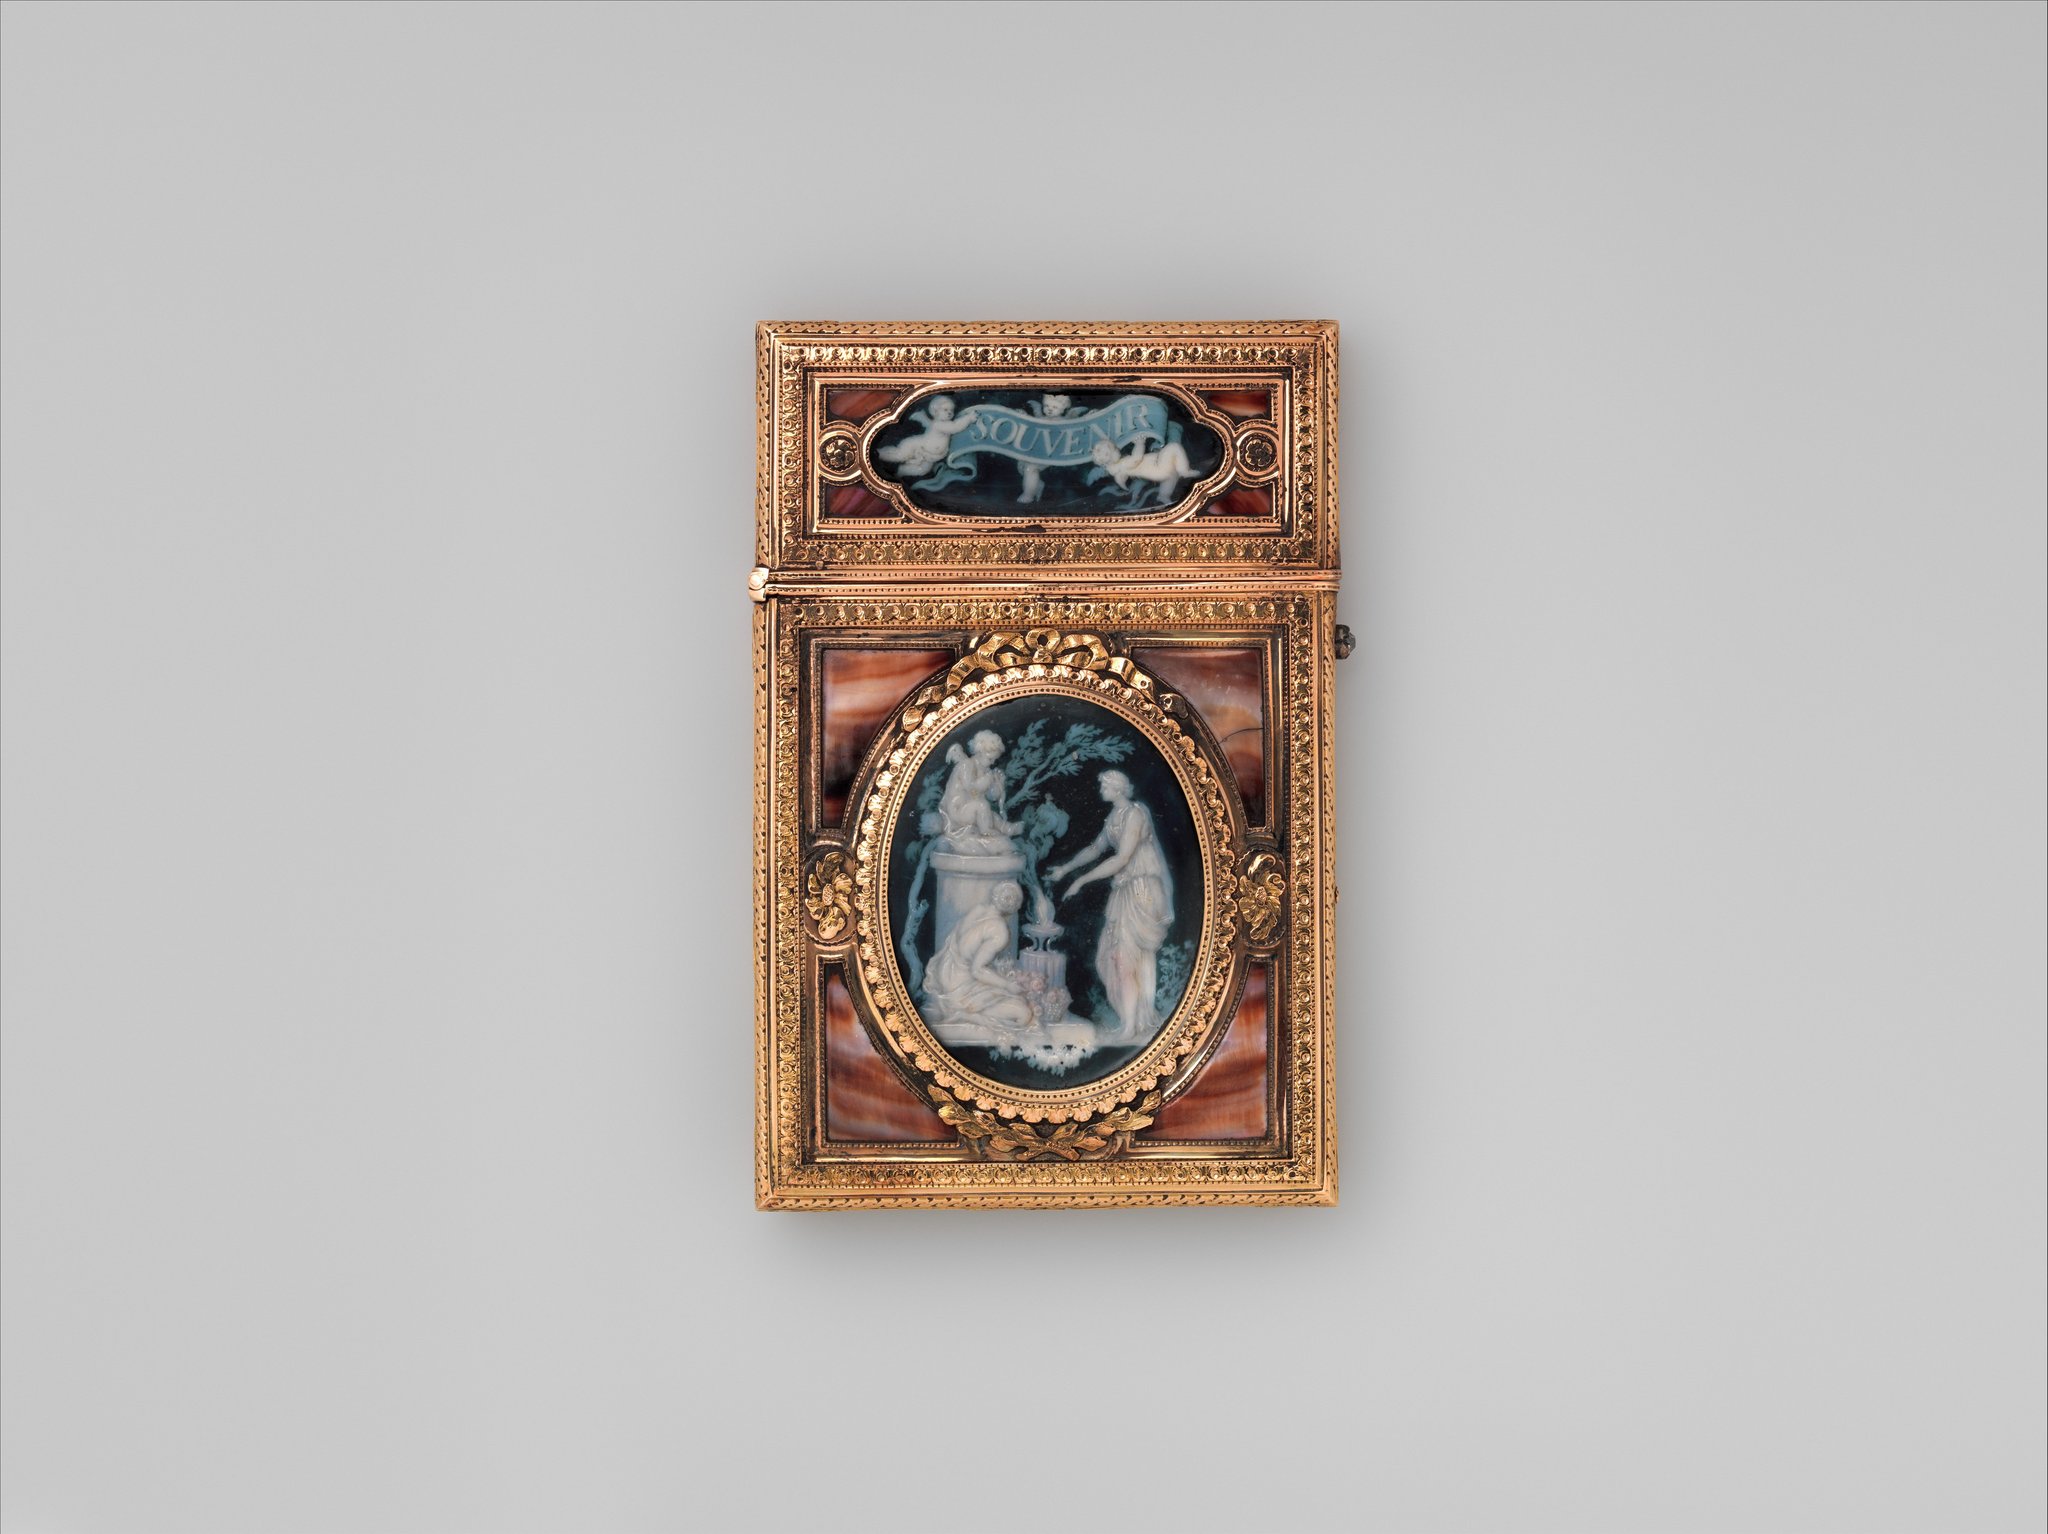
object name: souvenir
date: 1768-1775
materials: diamond, gold, mother of pearl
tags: women,cupid